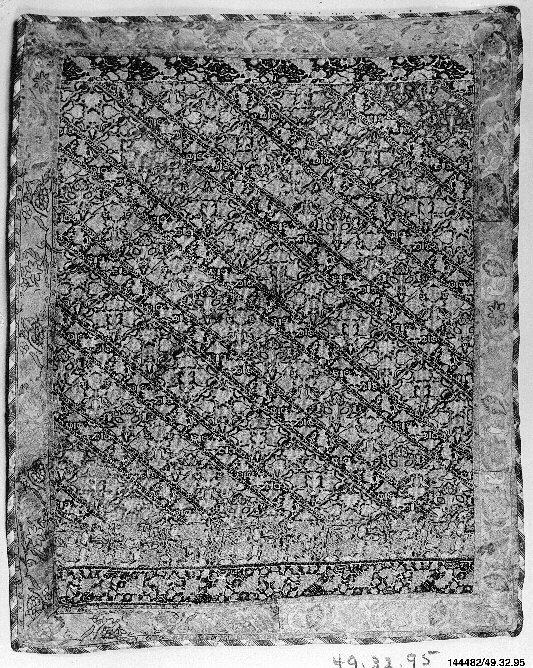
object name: trousering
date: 1701-1800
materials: linen, thread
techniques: embroidery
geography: iran